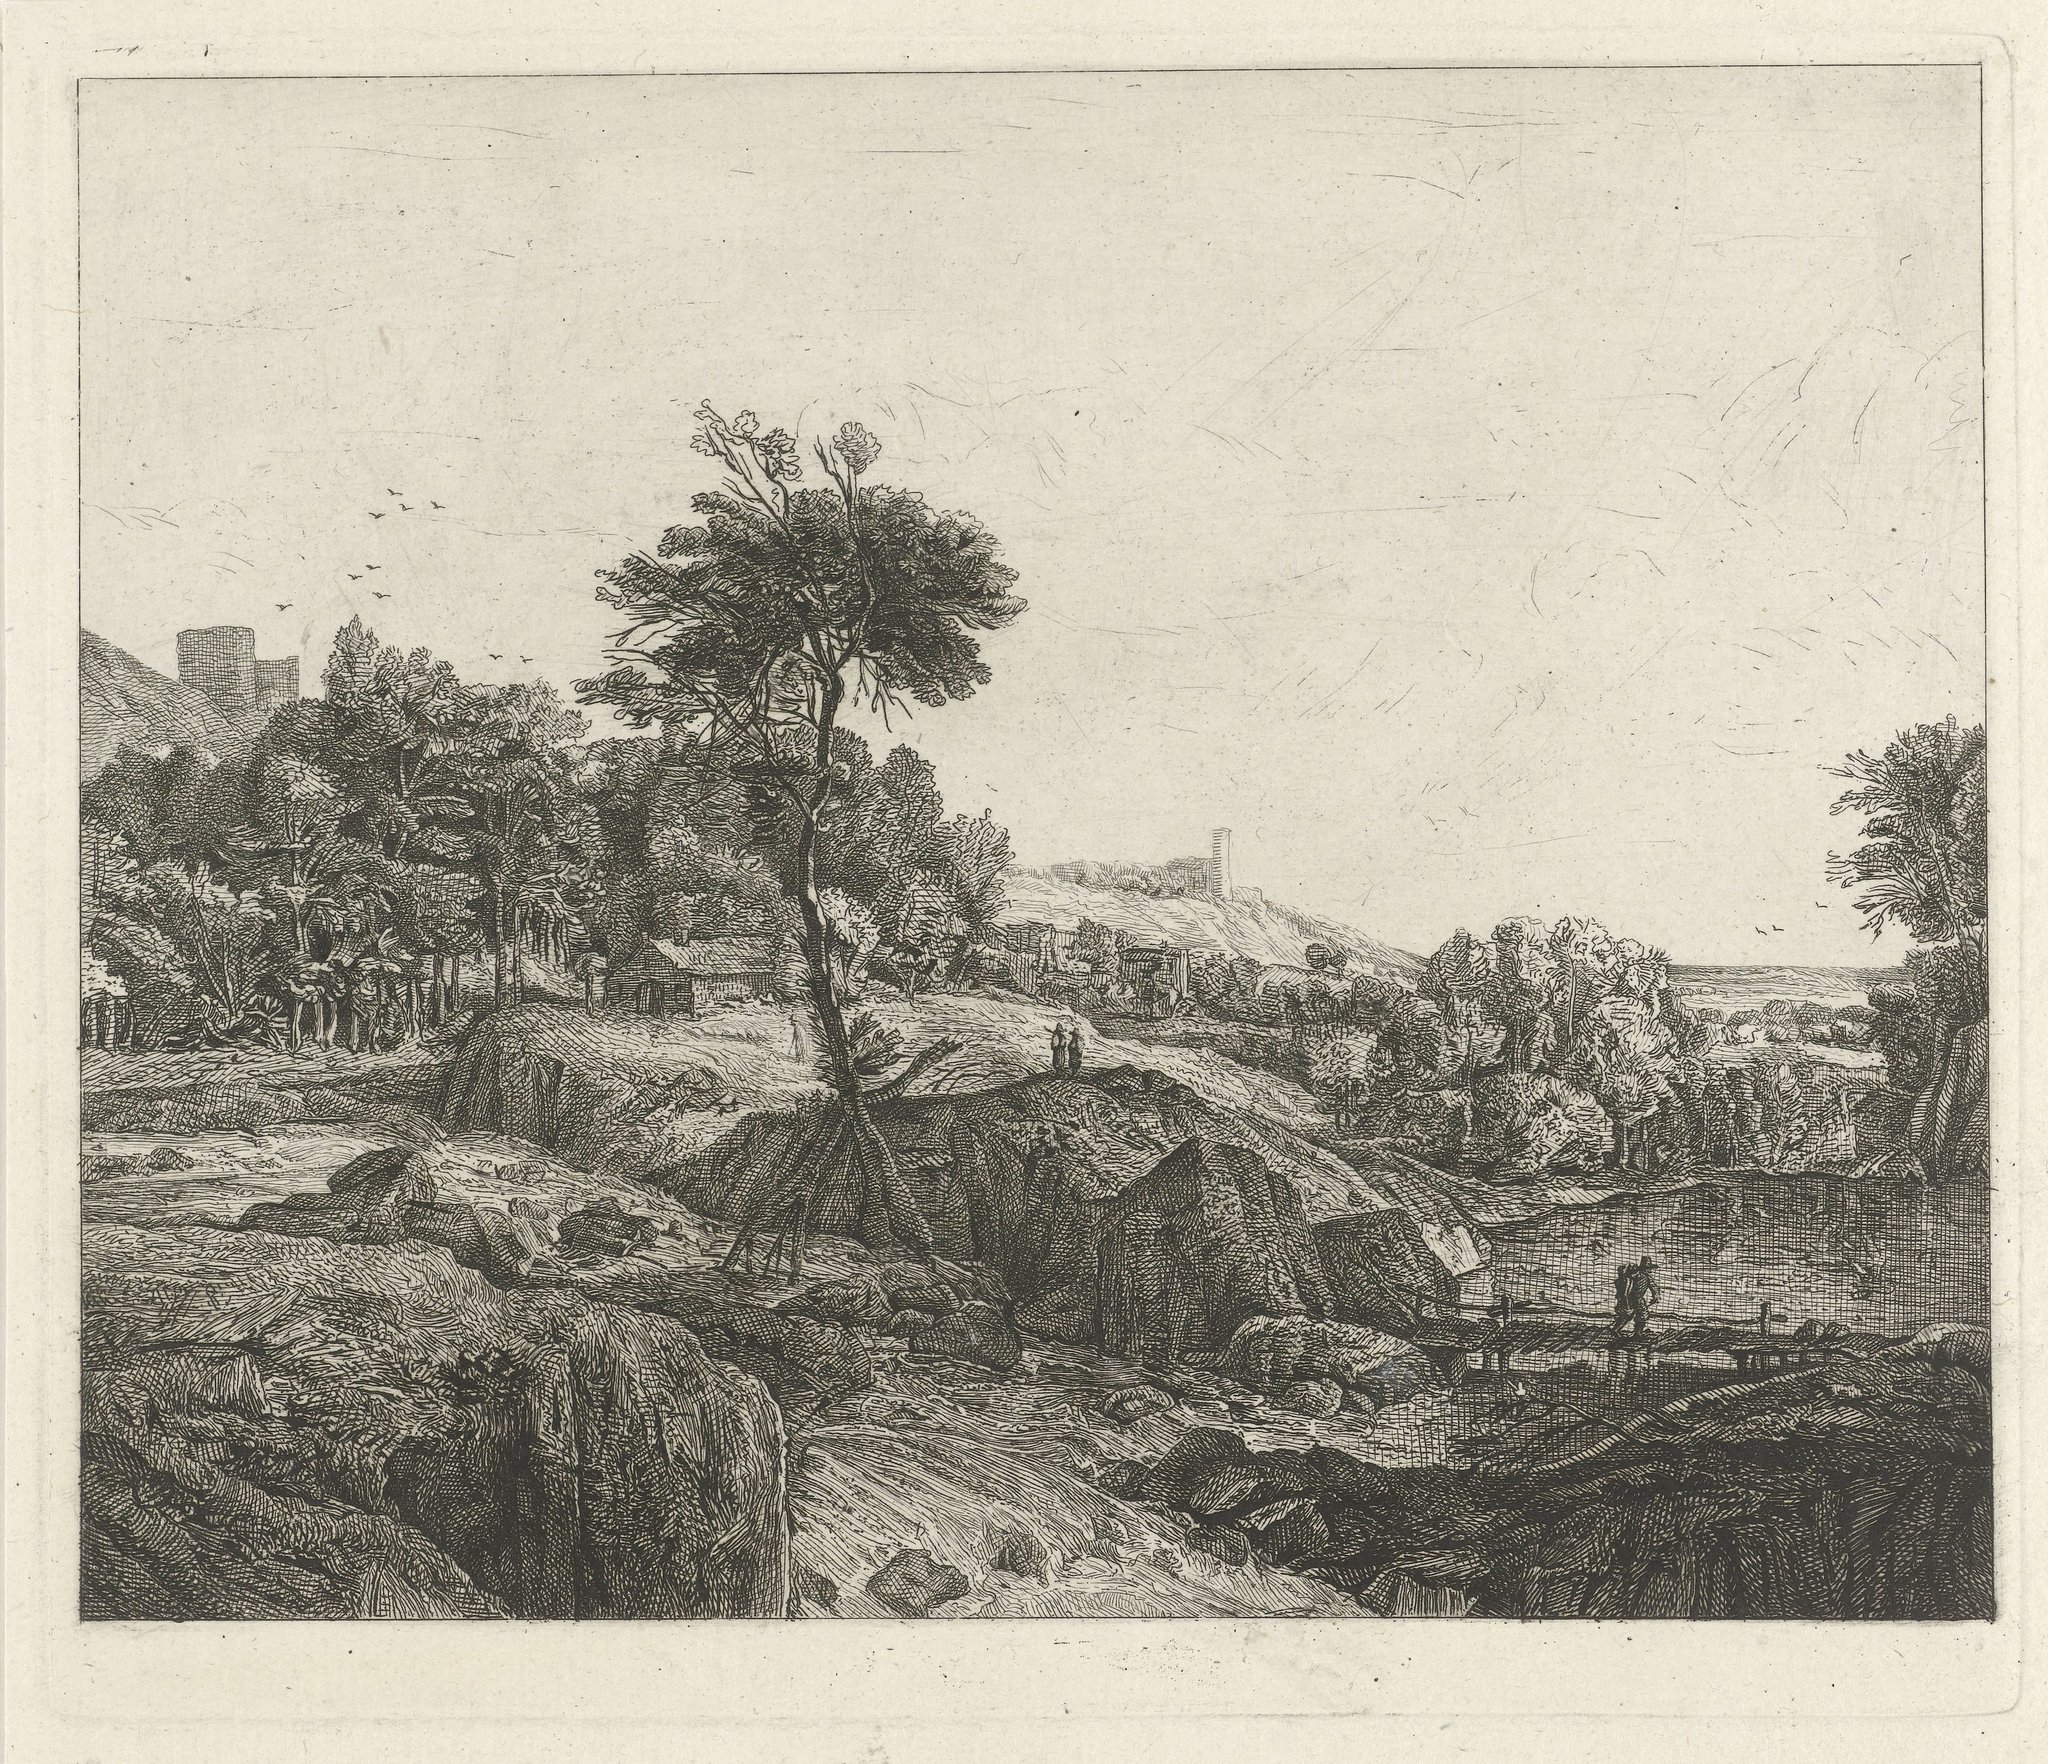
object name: print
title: Rotsachtig landschap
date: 1801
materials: paper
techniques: etching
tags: rocks - hh - ideal landscapes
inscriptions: collector's mark: Lugt 2228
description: Landschap met rotsen en een stromende beek. Iets links van het midden staat een boom, rechts loopt een figuur over een brug.